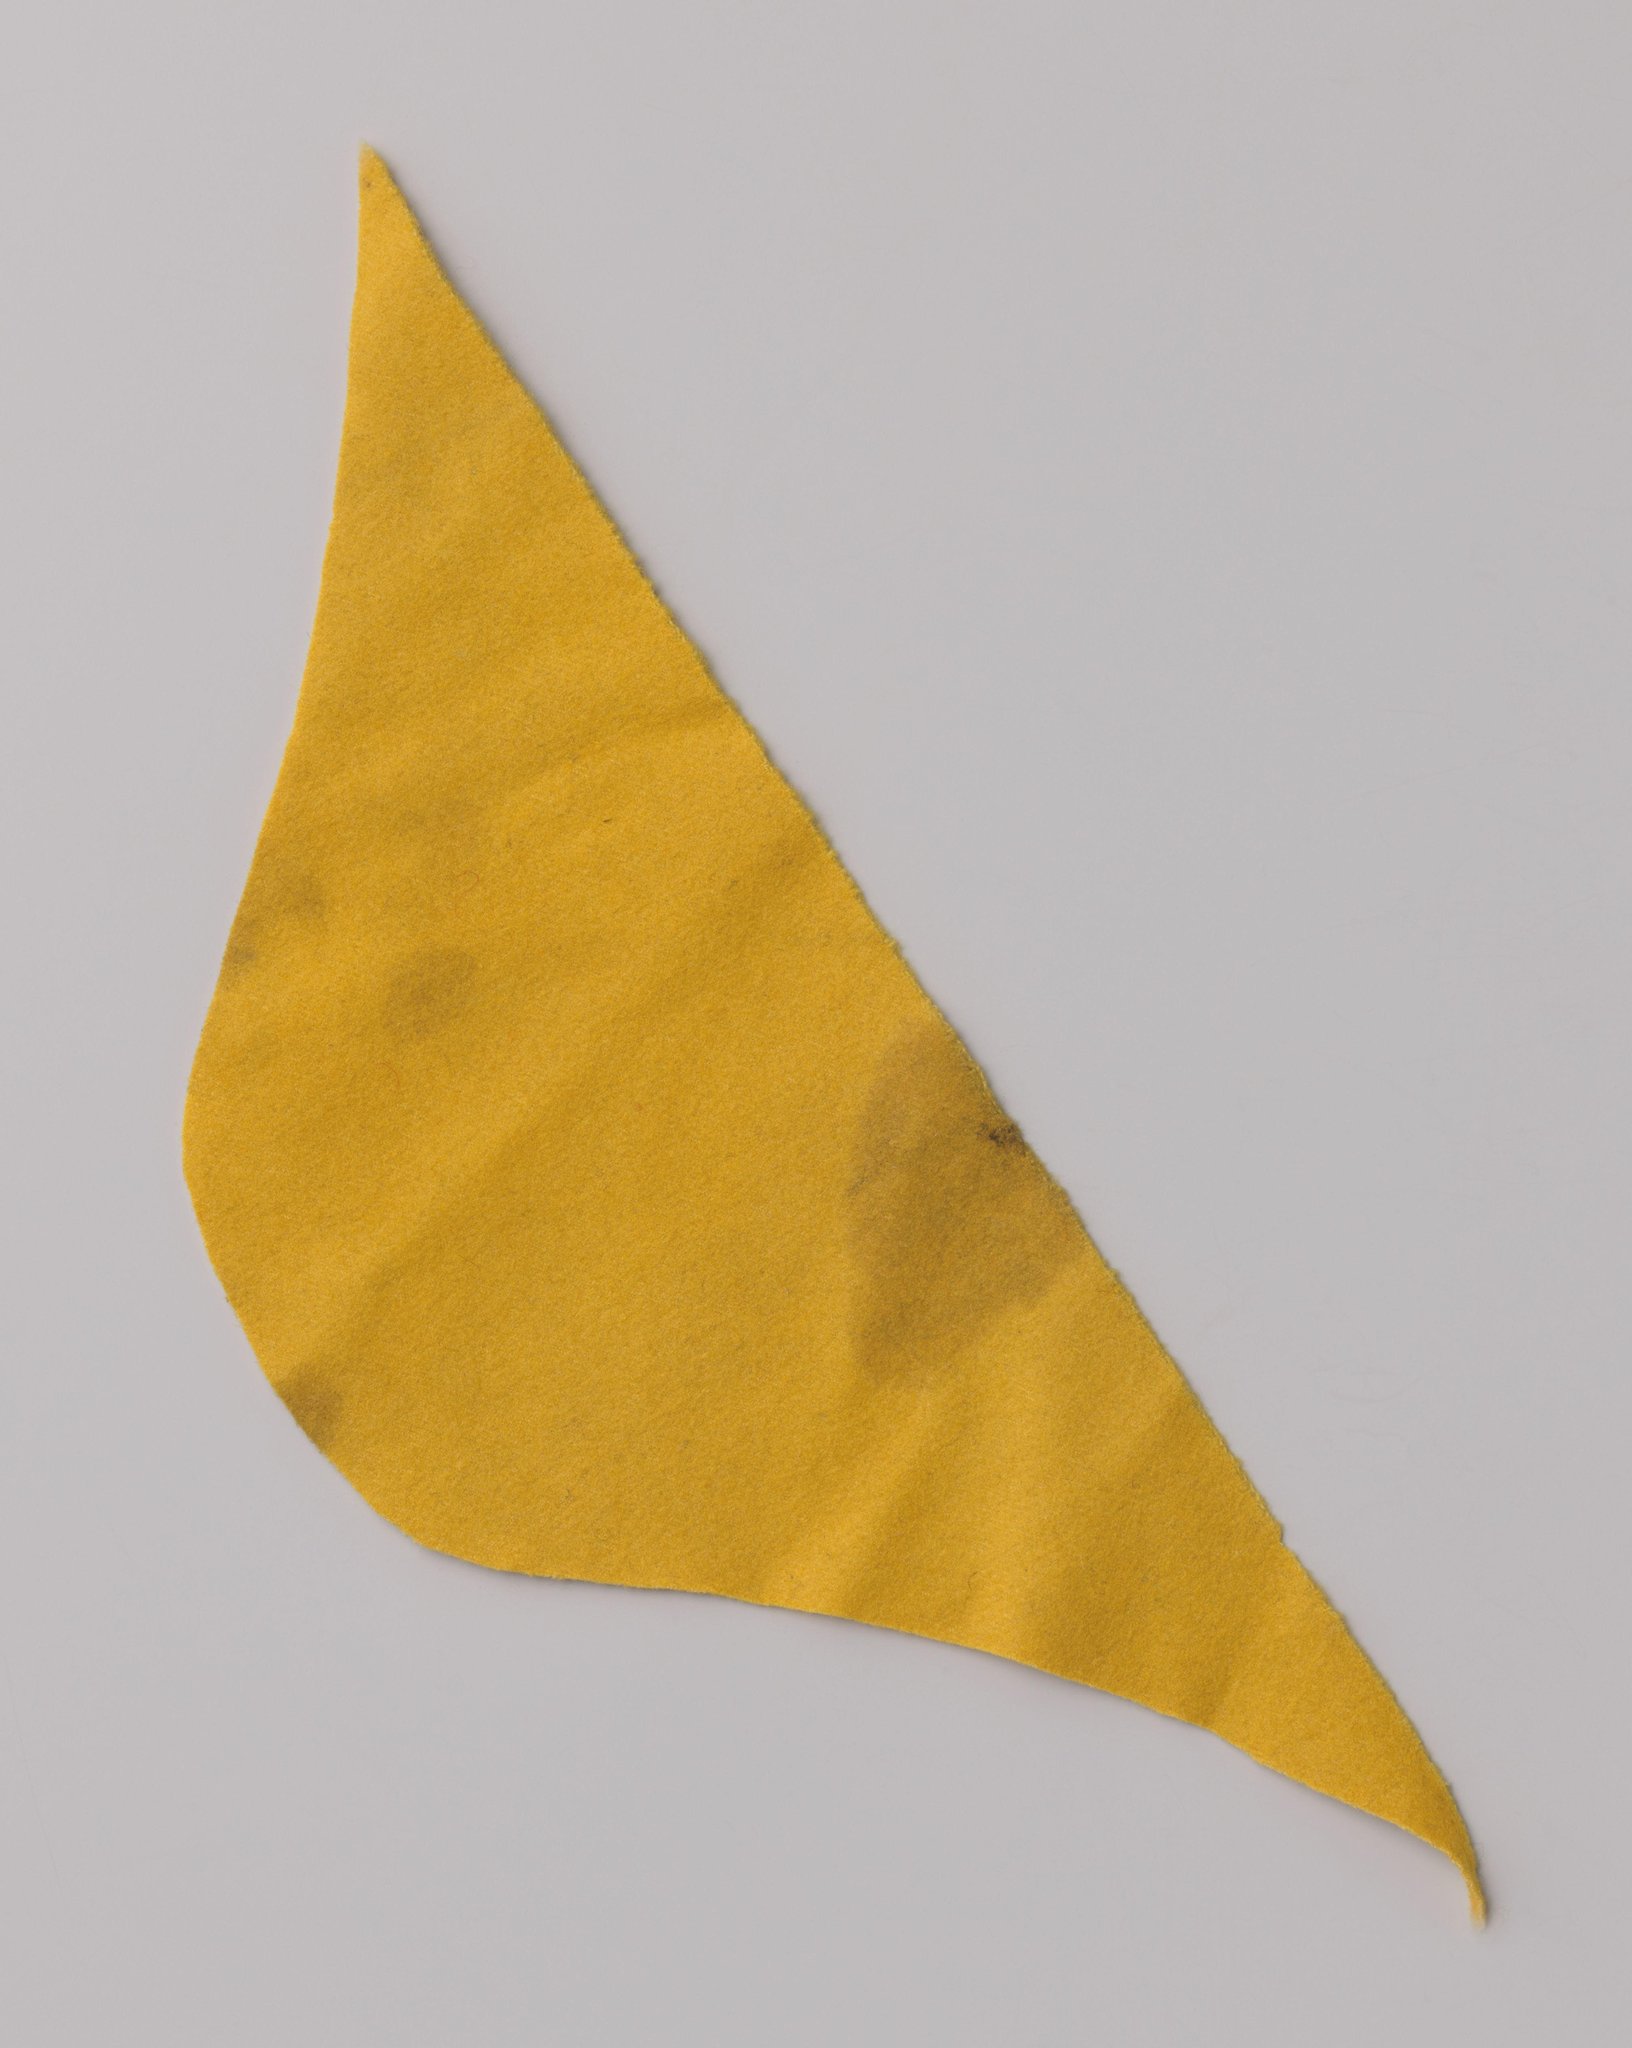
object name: coupon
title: Linnen, geel, uitmonsteringslaken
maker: Anonymous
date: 1800-1850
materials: textile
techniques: weave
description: Stuk geel linnen met vlekken. In pakket met etiket: Rijksmuseum, Amsterdam. Nederlandse leger, mariniers. Diverse stukken uniform stof en/of uitmonsteringslaken.